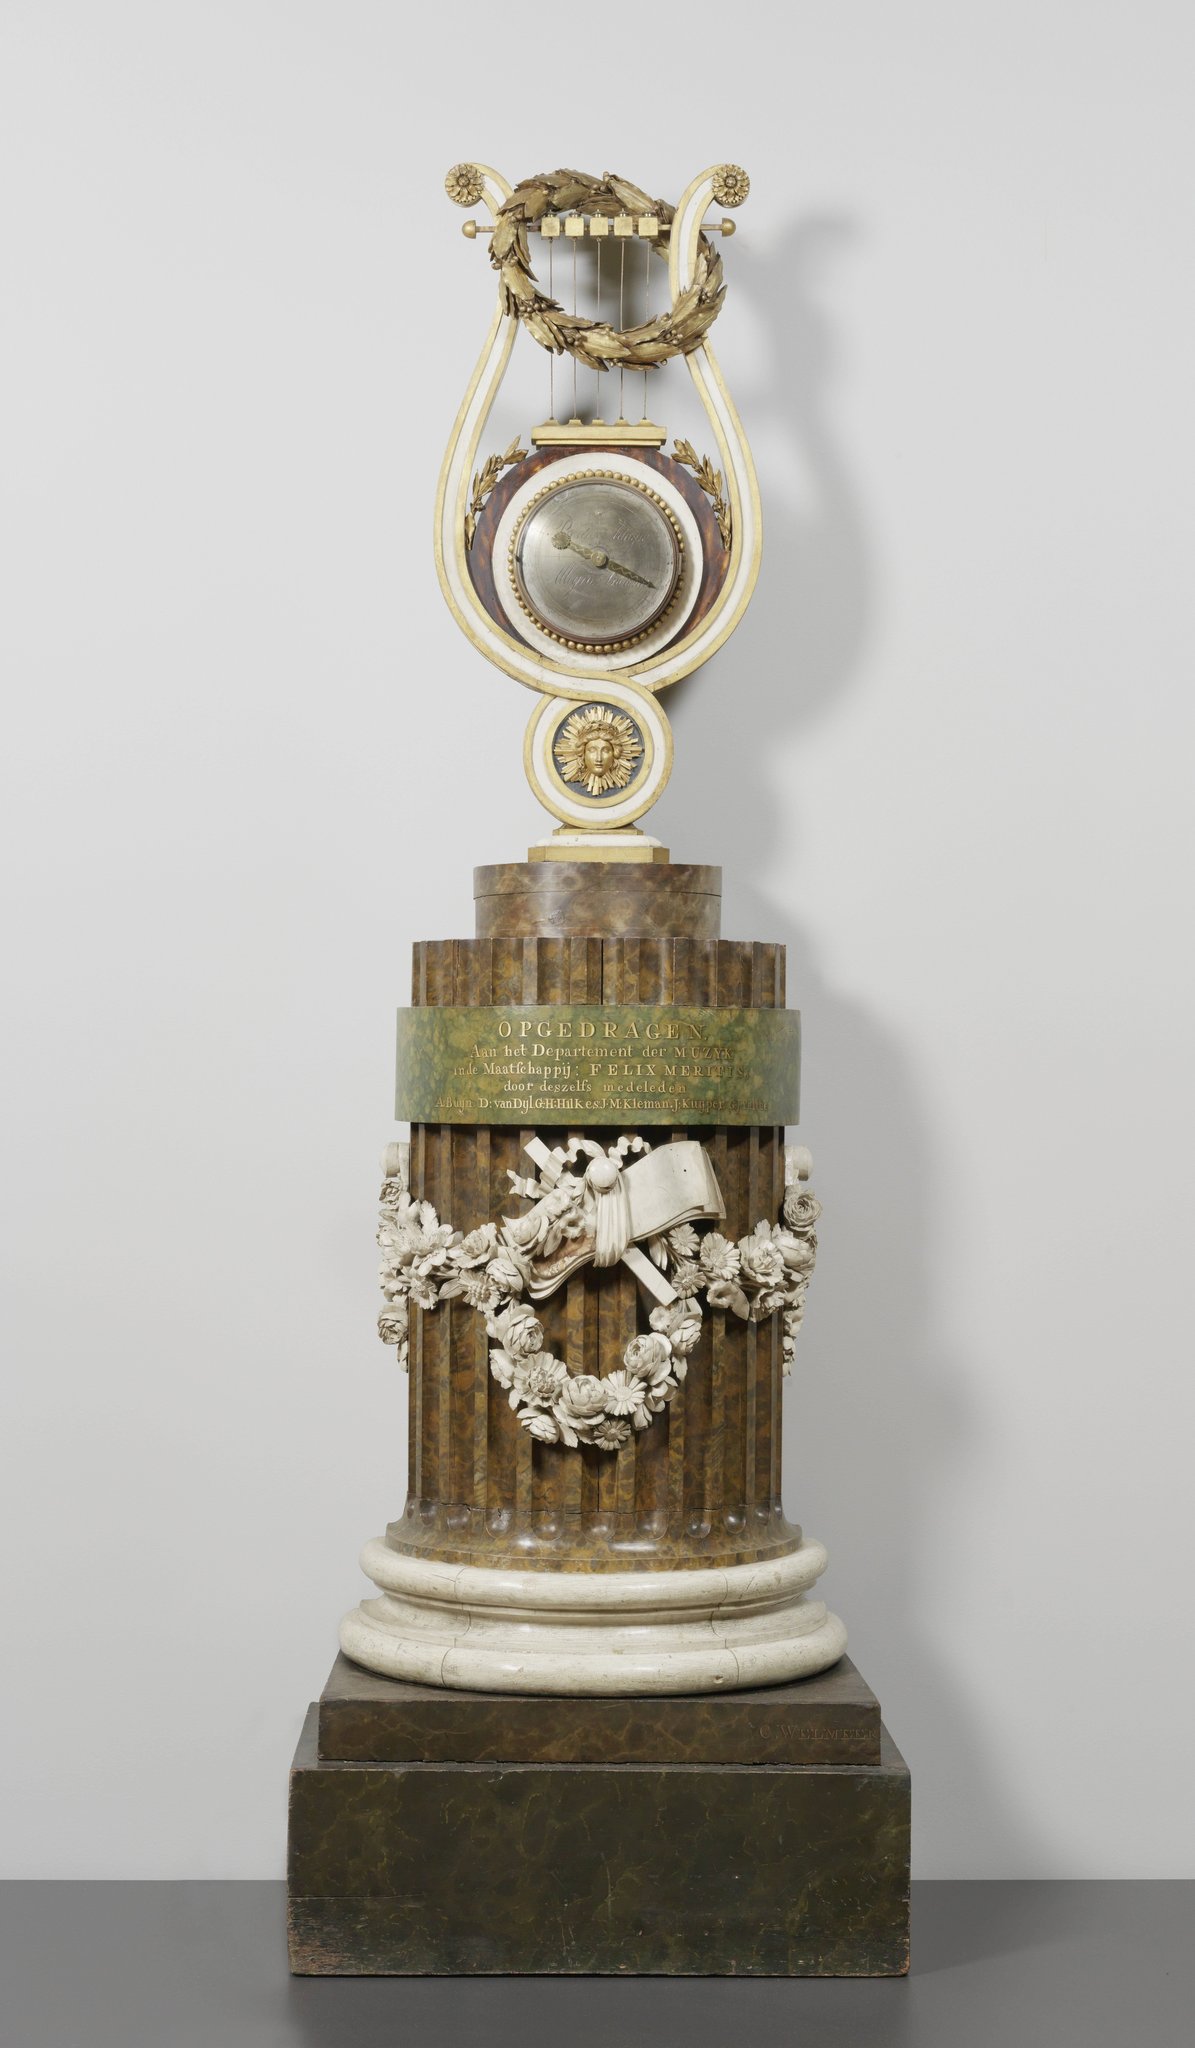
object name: metronome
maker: christiaan welmeer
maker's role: draughtsman, sculptor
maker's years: 1742-1814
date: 1803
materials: brass, glass, wood, paint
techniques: gilding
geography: amsterdam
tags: ornament ~ festoon, garland, amsterdam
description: A metronome is a device for keeping time (a steady beat) while playing music. This example was given by several members of the Felix Meritis Society to its music department. It is shaped like a lyre surmounted by a laurel wreath, symbolizing the Triumph of Music.